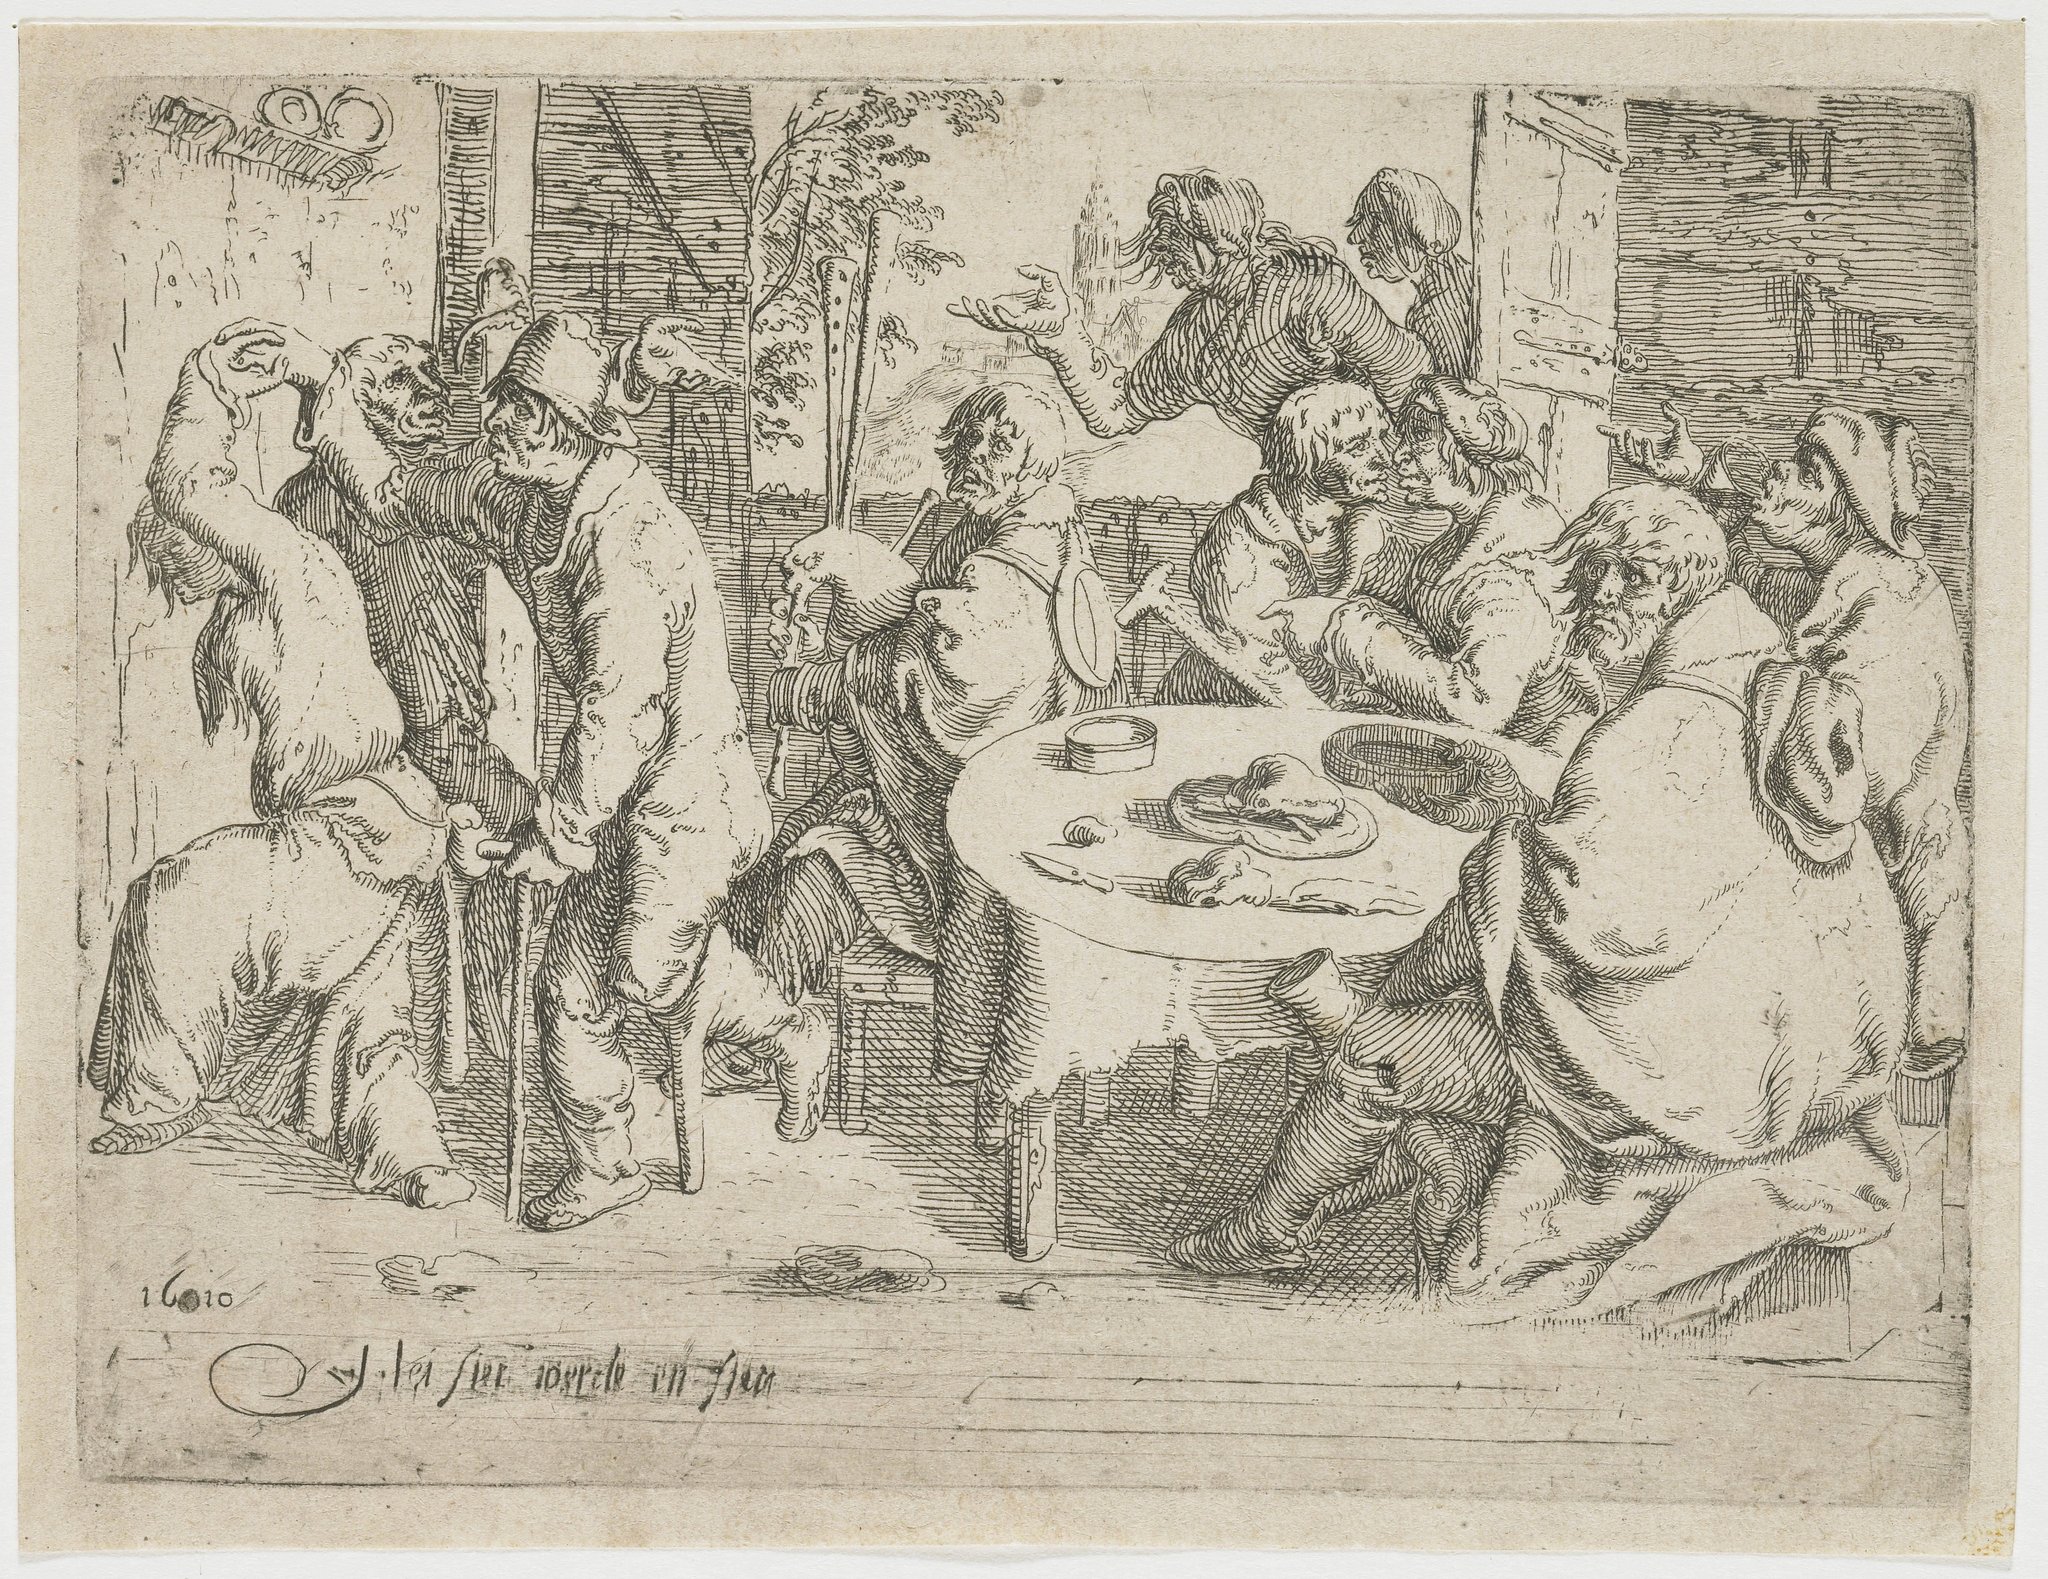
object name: print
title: Drie bedelaars en een vrouw aan tafel in een herberg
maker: joost cornelisz droochsloot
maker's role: painter, print maker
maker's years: 1585-1666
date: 1610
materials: paper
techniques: etching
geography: utrecht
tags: one person playing wind instrument, bagpipe, musette, one pair dancing; man and woman dancing as a couple, disabilities, deformations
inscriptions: collector's mark: Lugt 240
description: Drie bedelaars zitten in een herberg aan tafel. De ene wordt vergezeld door een vrouw. Op een stoel bij het raam zit een doedelzakspeler. Links danst een kreupel met een andere bedelaar.